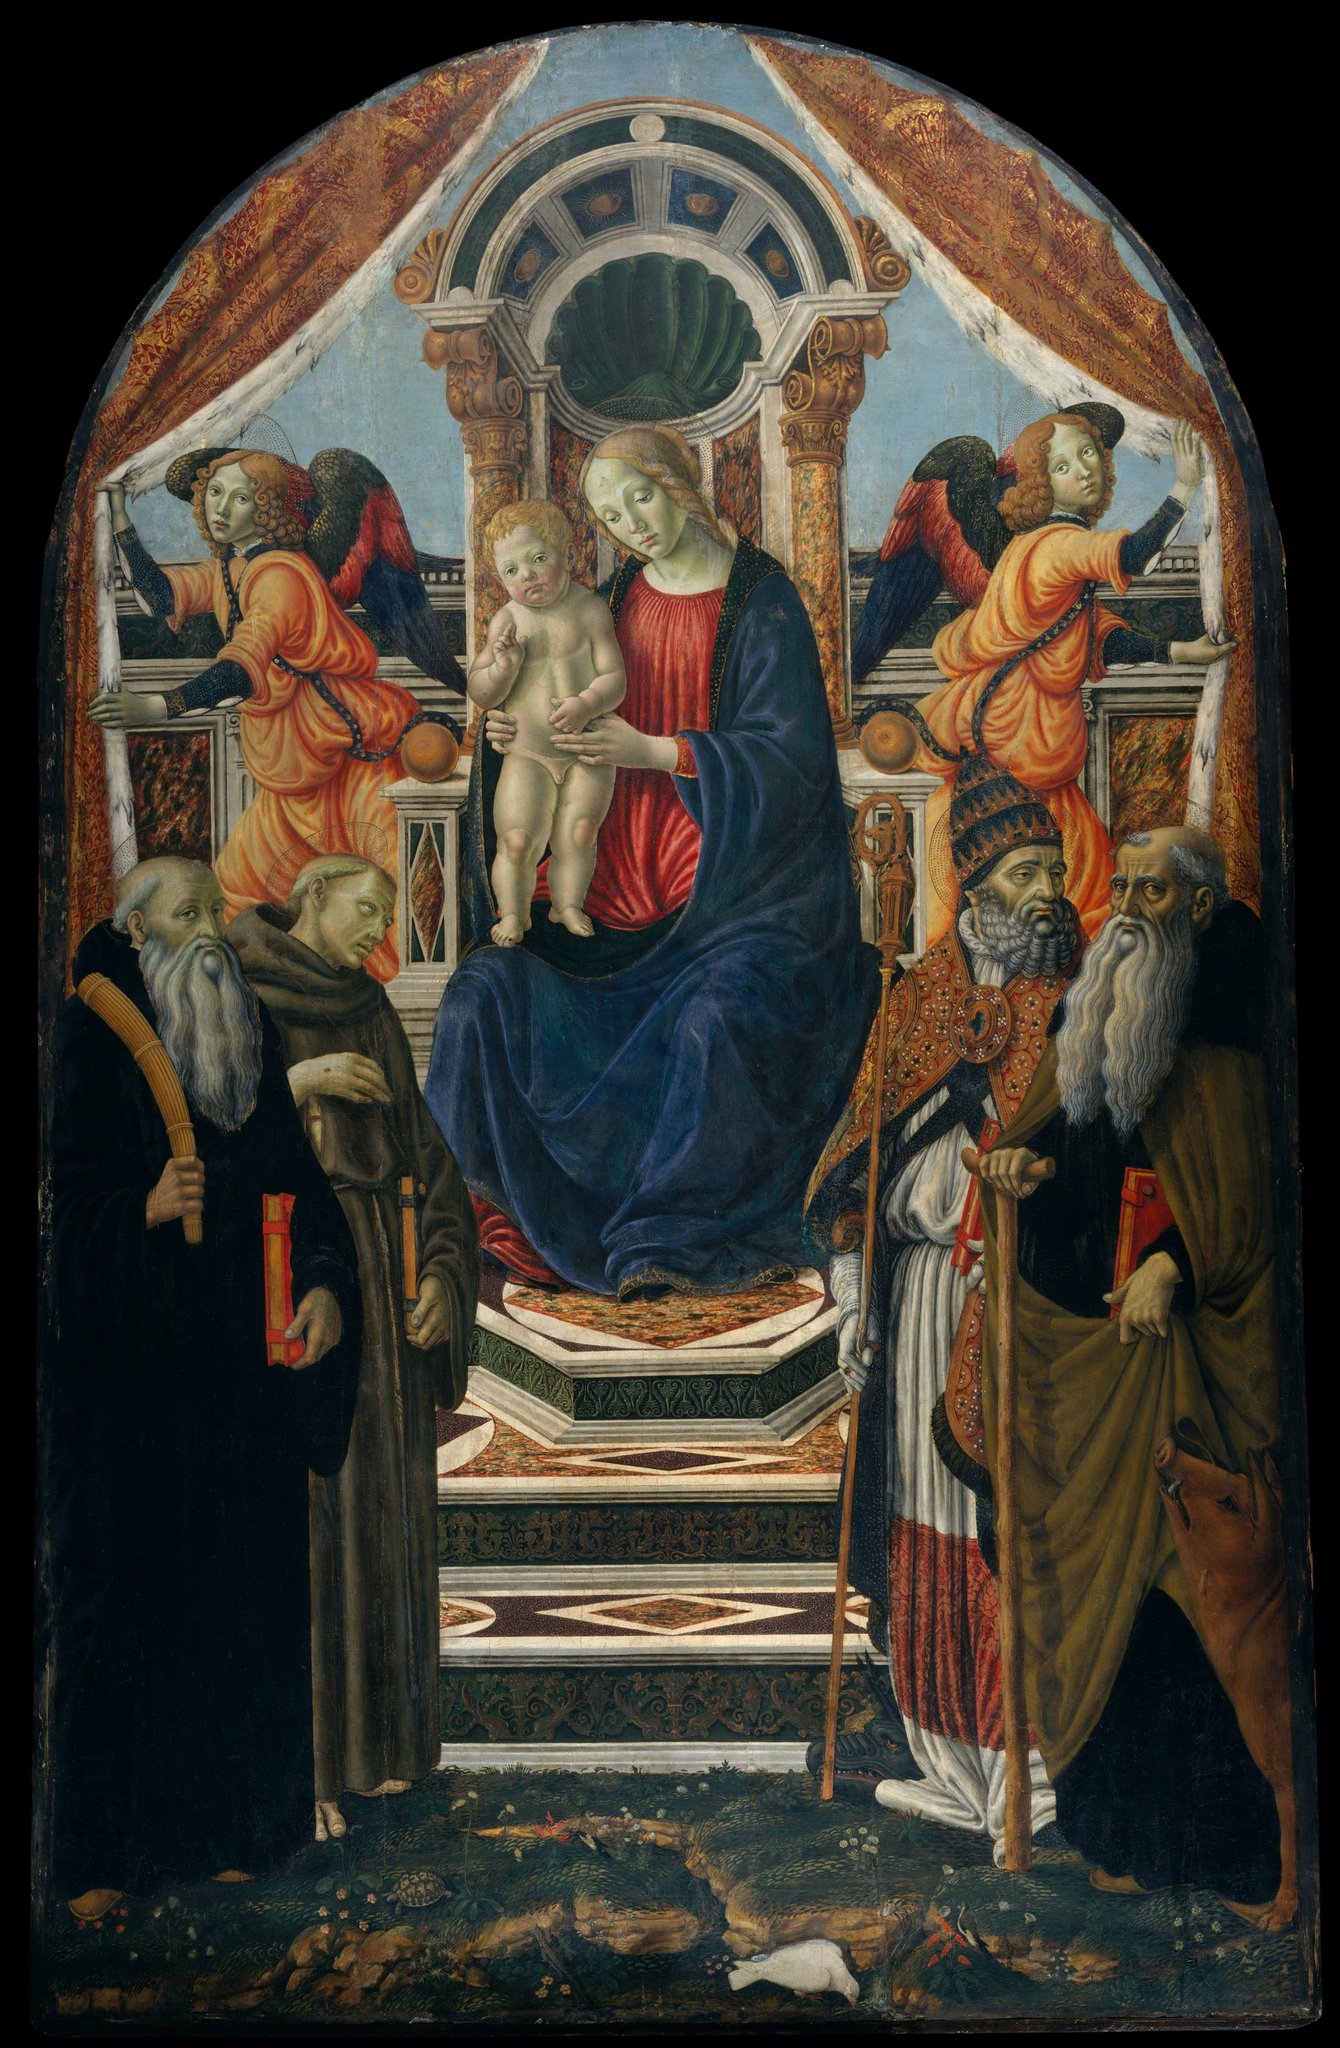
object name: painting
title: Madonna and Child Enthroned with Saints and Angels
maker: francesco botticini (francesco di giovanni)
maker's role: artist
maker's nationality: italian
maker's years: 1446-1497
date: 1493-1495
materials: paint, wood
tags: angels,madonna and child,saints